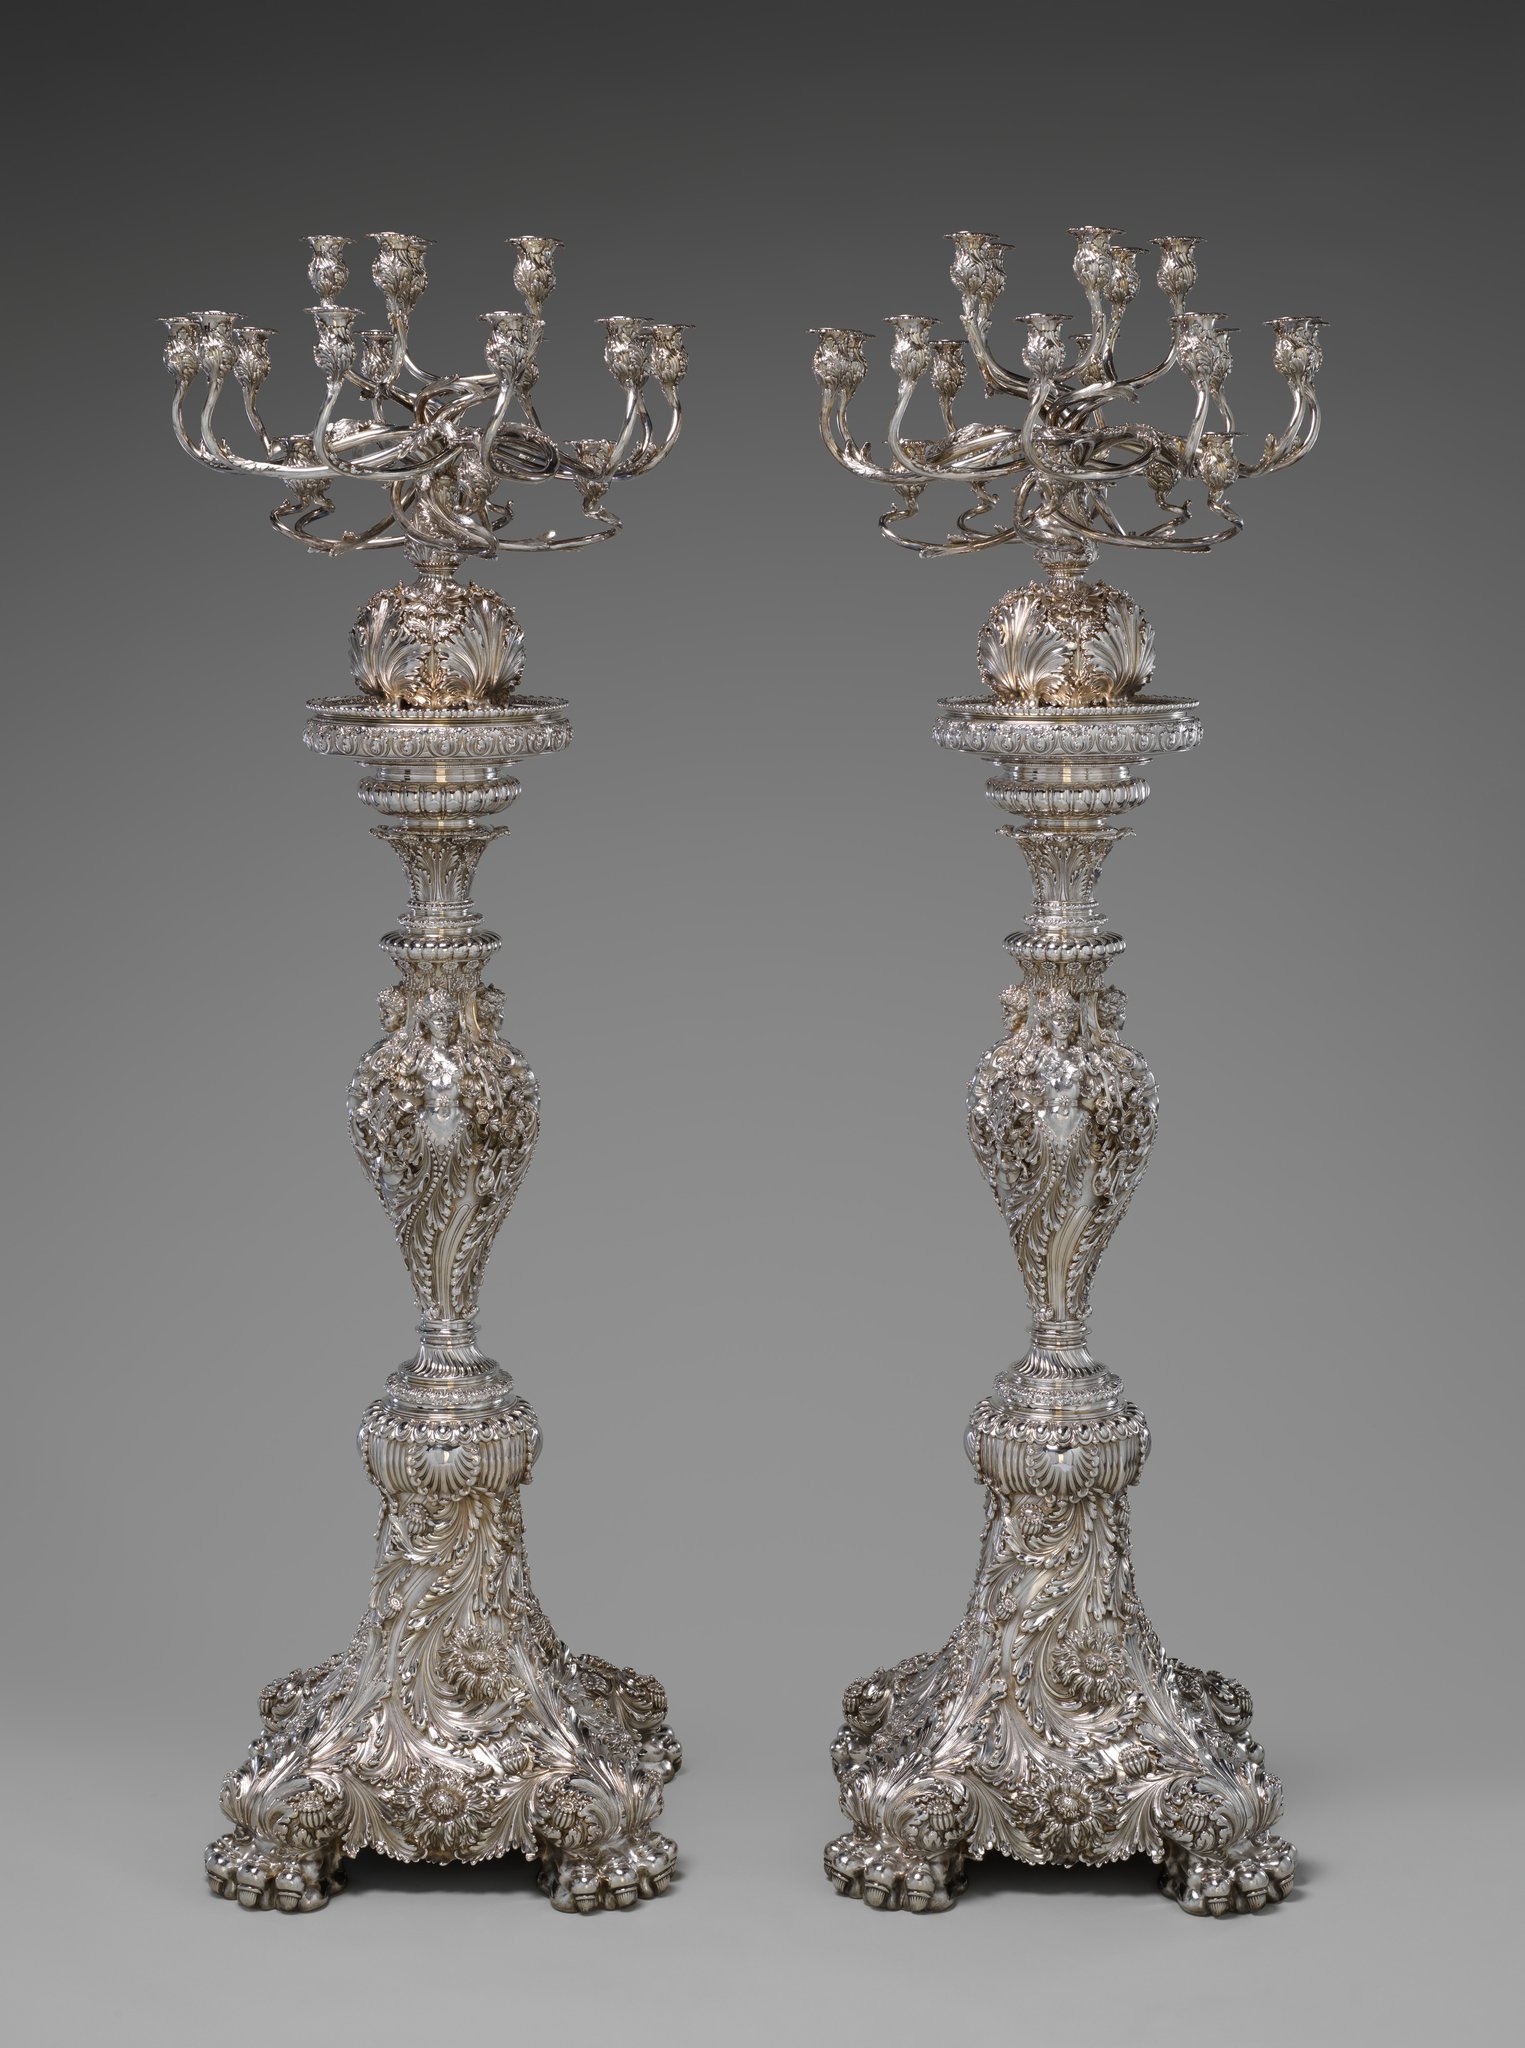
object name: pair of candelabra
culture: american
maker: tiffany & co.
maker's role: artist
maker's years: 1837-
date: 1884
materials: silver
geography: united states